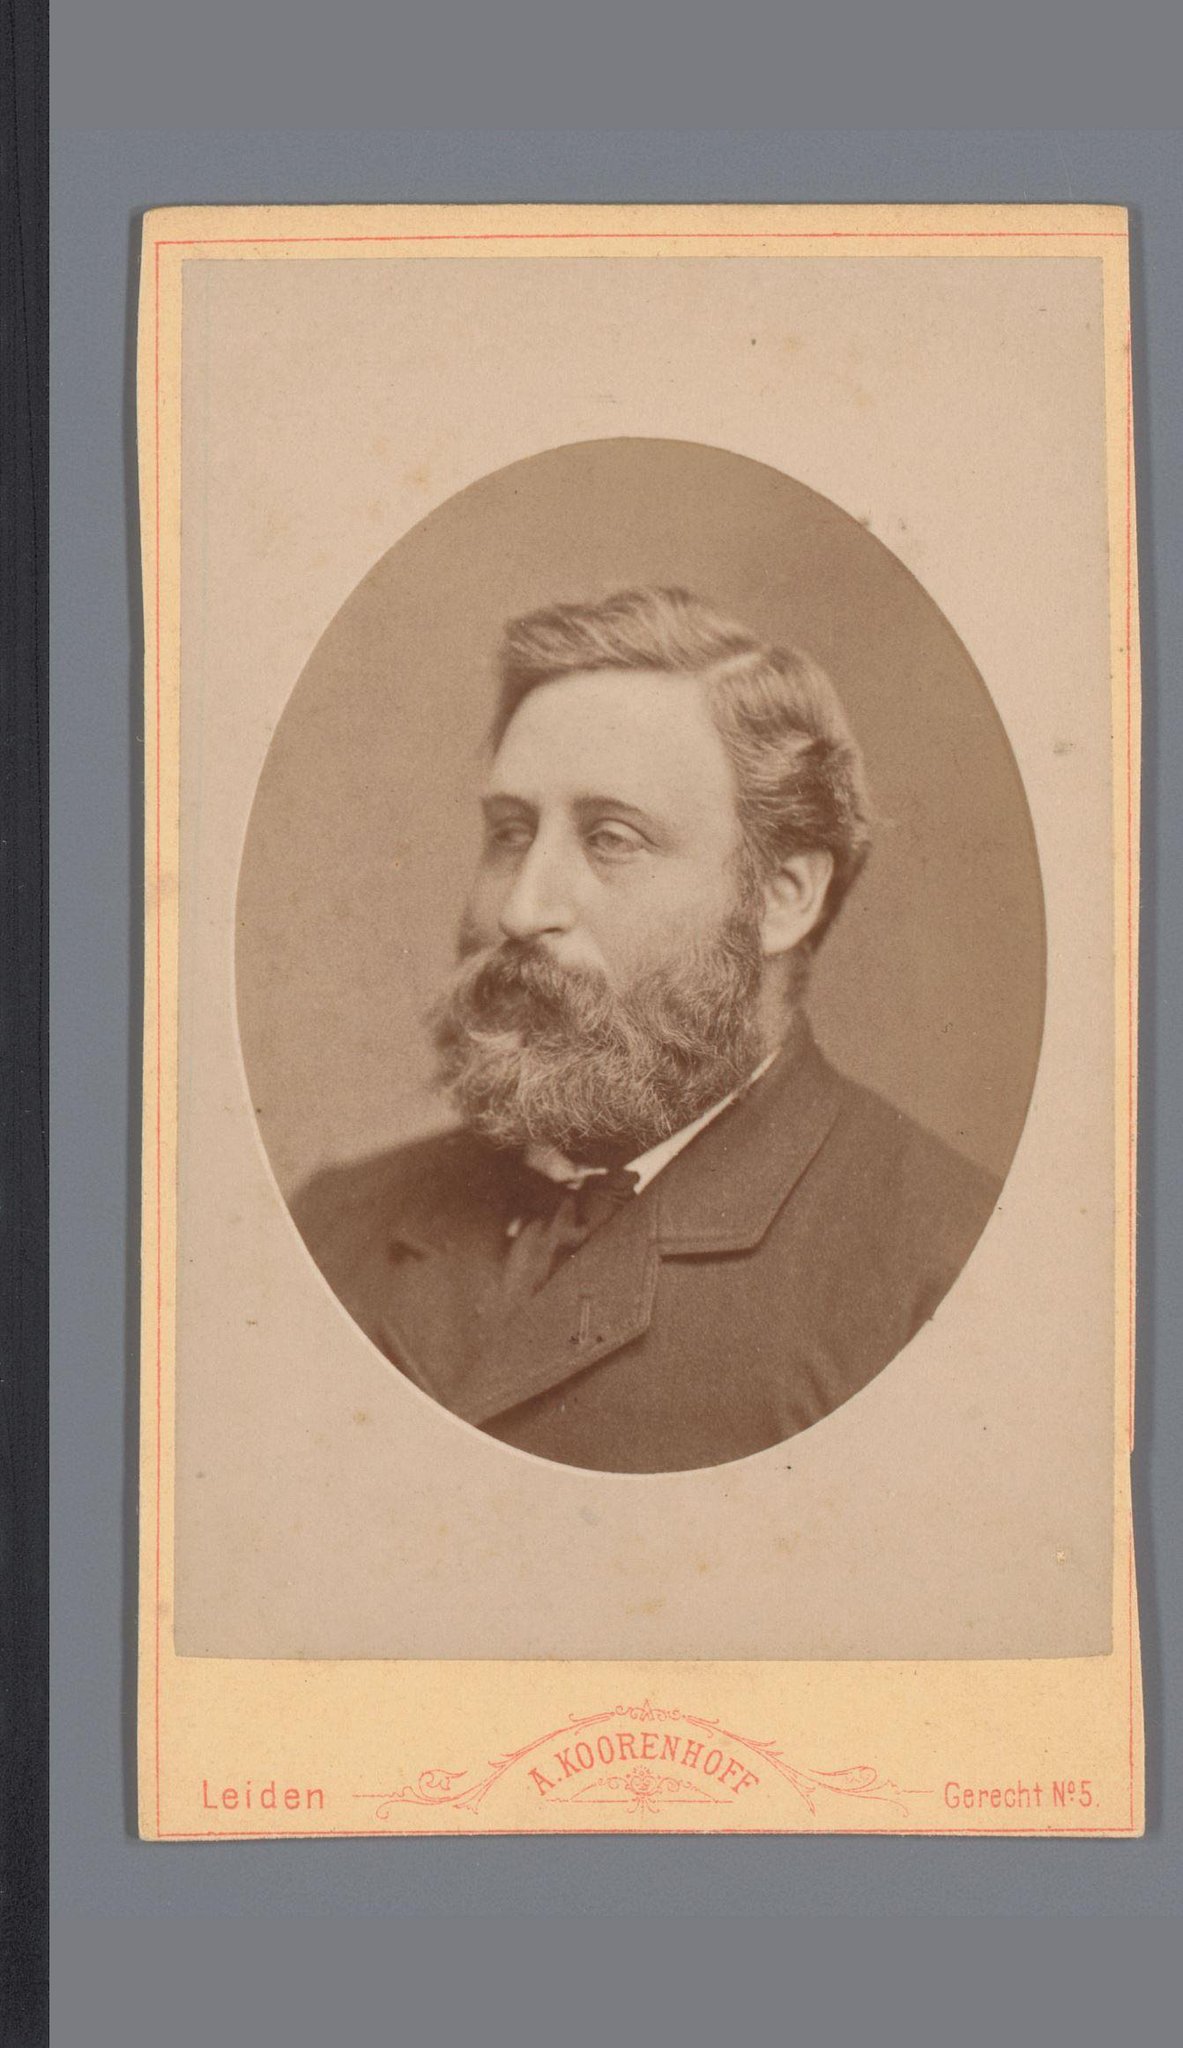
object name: photograph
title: Portret van J. van Raal van Konijnenburg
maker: abraham koorenhoff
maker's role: fotograaf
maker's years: 1844-1917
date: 1892-1893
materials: cardboard, photographic support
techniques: albumen print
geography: leiden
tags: historical persons, leiden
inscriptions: annotation: ‘J. van Raal van Konijnenburg [...]’, workshop stamp: ‘A. Koorenhoff/ Photographe van Z.M. den Koning der Nederlanden/ te Leiden Gerecht No.5 by de Pieterskerk’